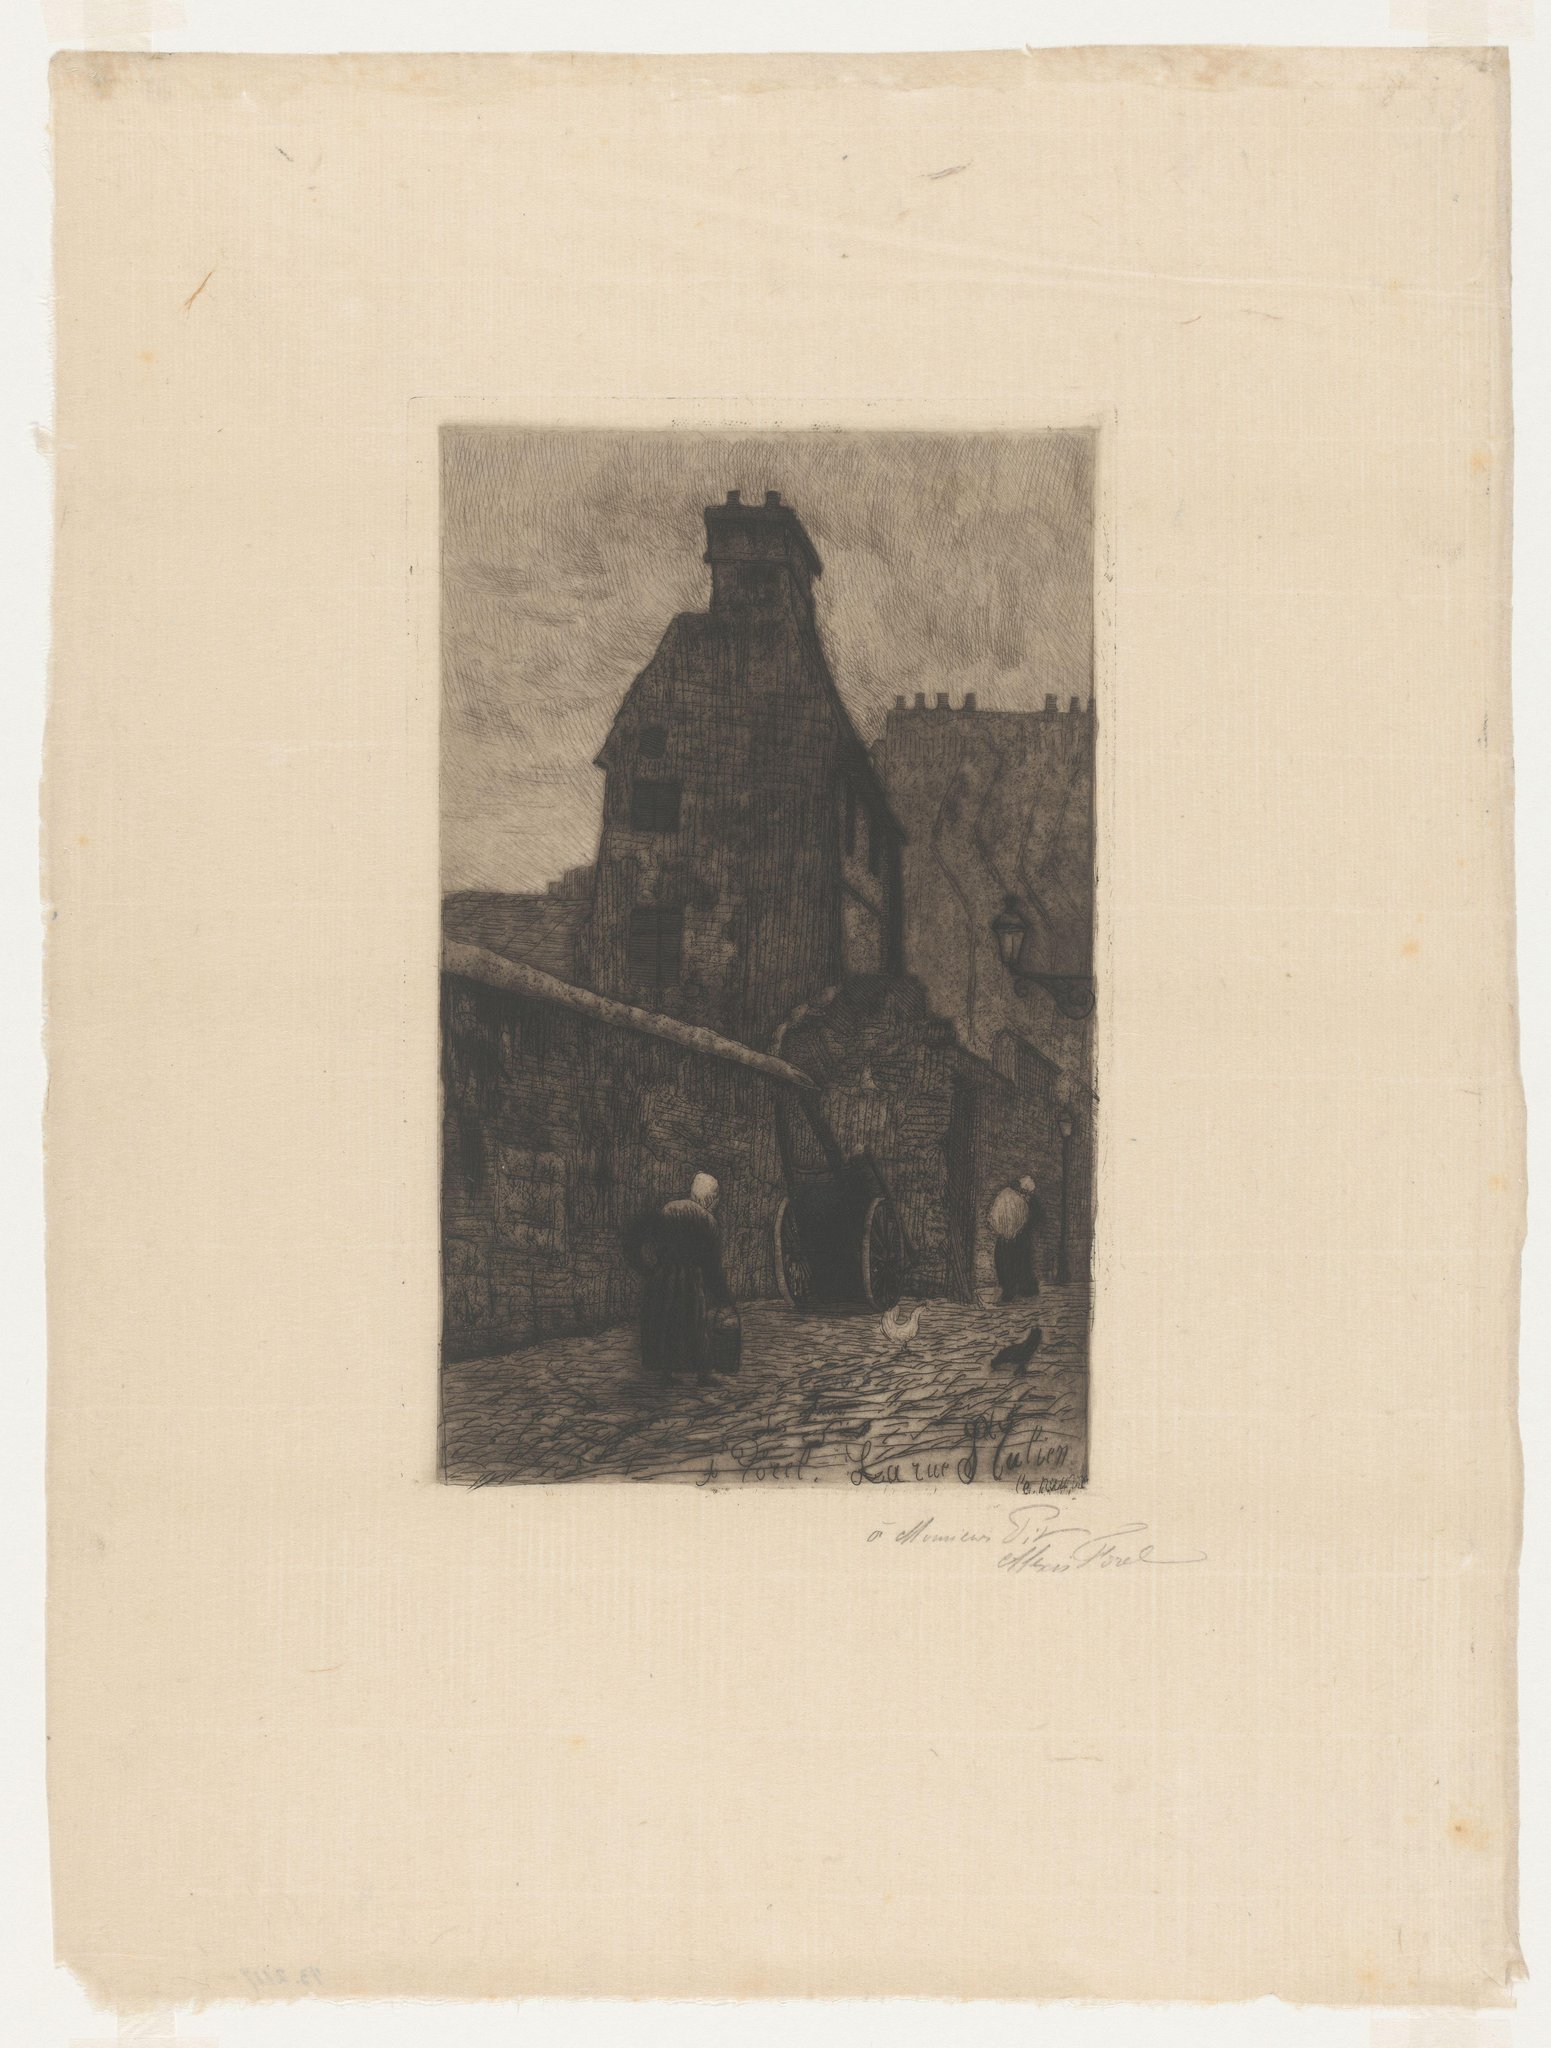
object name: print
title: La Rue S Julien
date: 1862-1913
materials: paper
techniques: drypoint, etching, intaglio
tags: traffic and transport, street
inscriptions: collector's mark: Lugt 2228